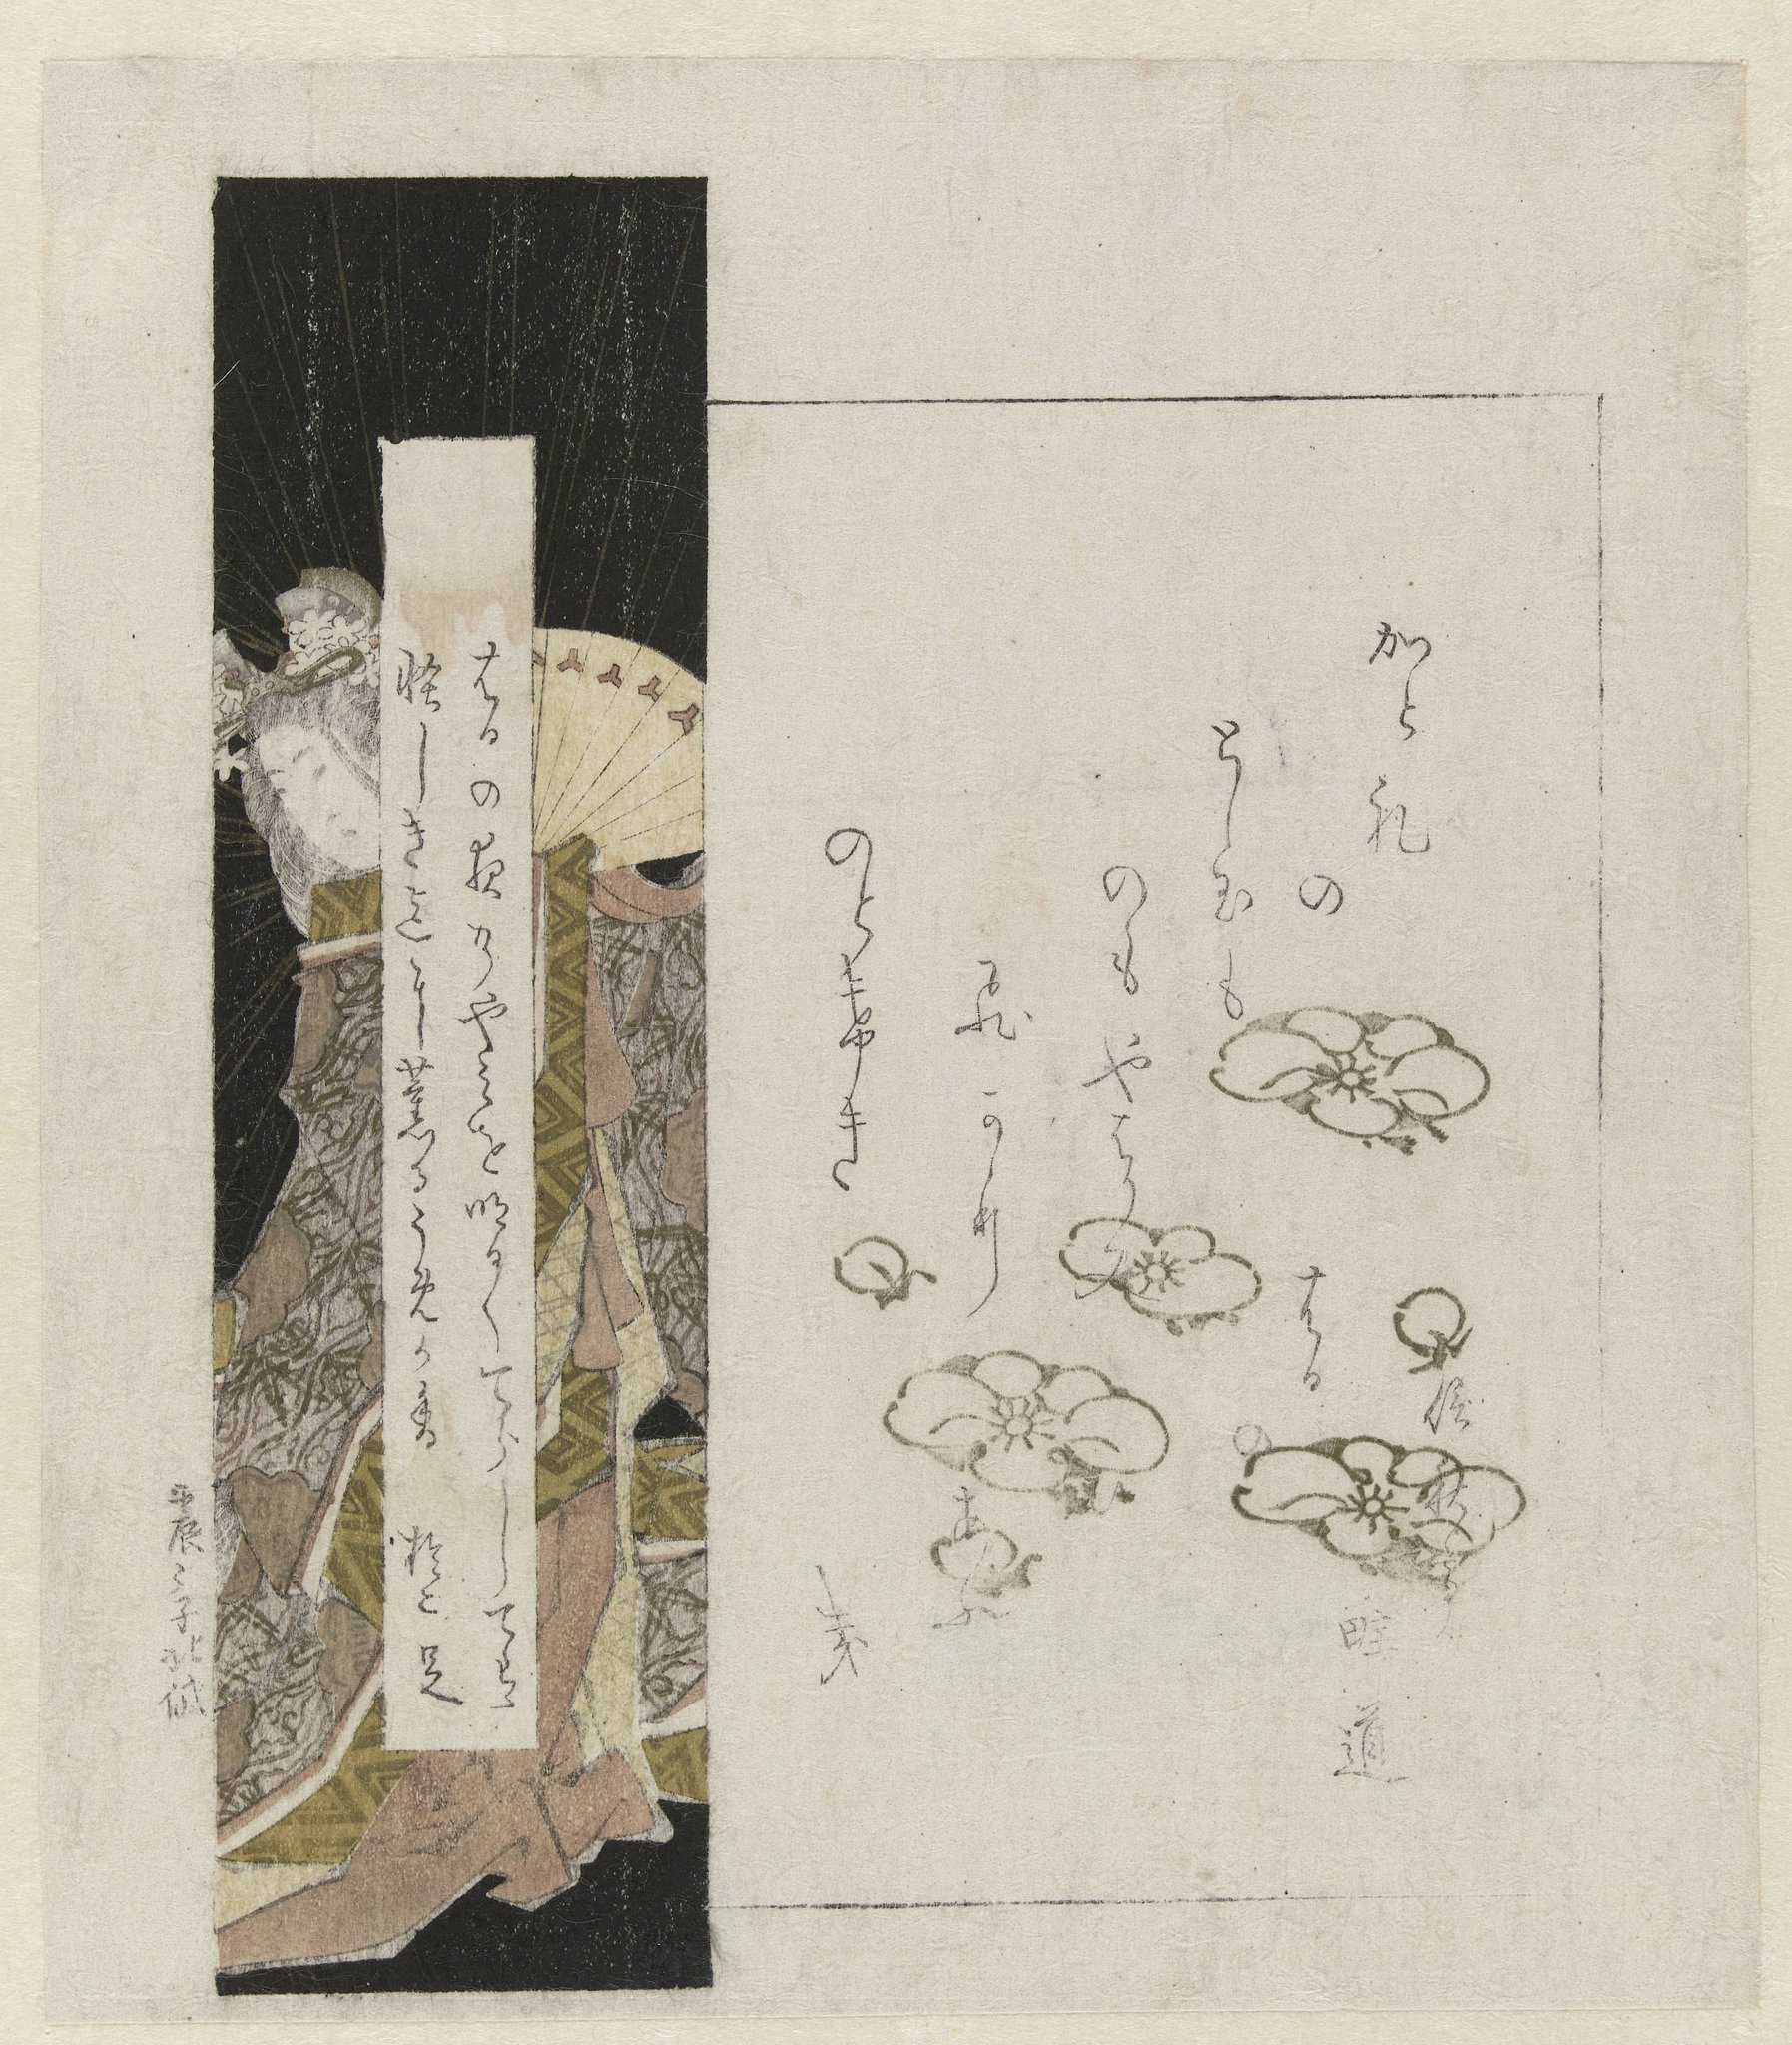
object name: surimono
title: Court Lady Holding a Fan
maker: katsushika hokutai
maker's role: print maker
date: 1815-1820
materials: paper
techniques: woodcut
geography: japan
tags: adult woman, fan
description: Een surimono is een luxe uitgevoerde prent waarop beeld met één of meerdere gedichten gecombineerd is. Bij het drukken van een surimono werd vaak gebruik gemaakt van dikker papier, blinddruk en metaal pigmenten, zoals koper- en zilverpoeder. De prenten werden vaak in opdracht van dichters gemaakt en als exclusief geschenk aan vrienden en relaties gegeven.